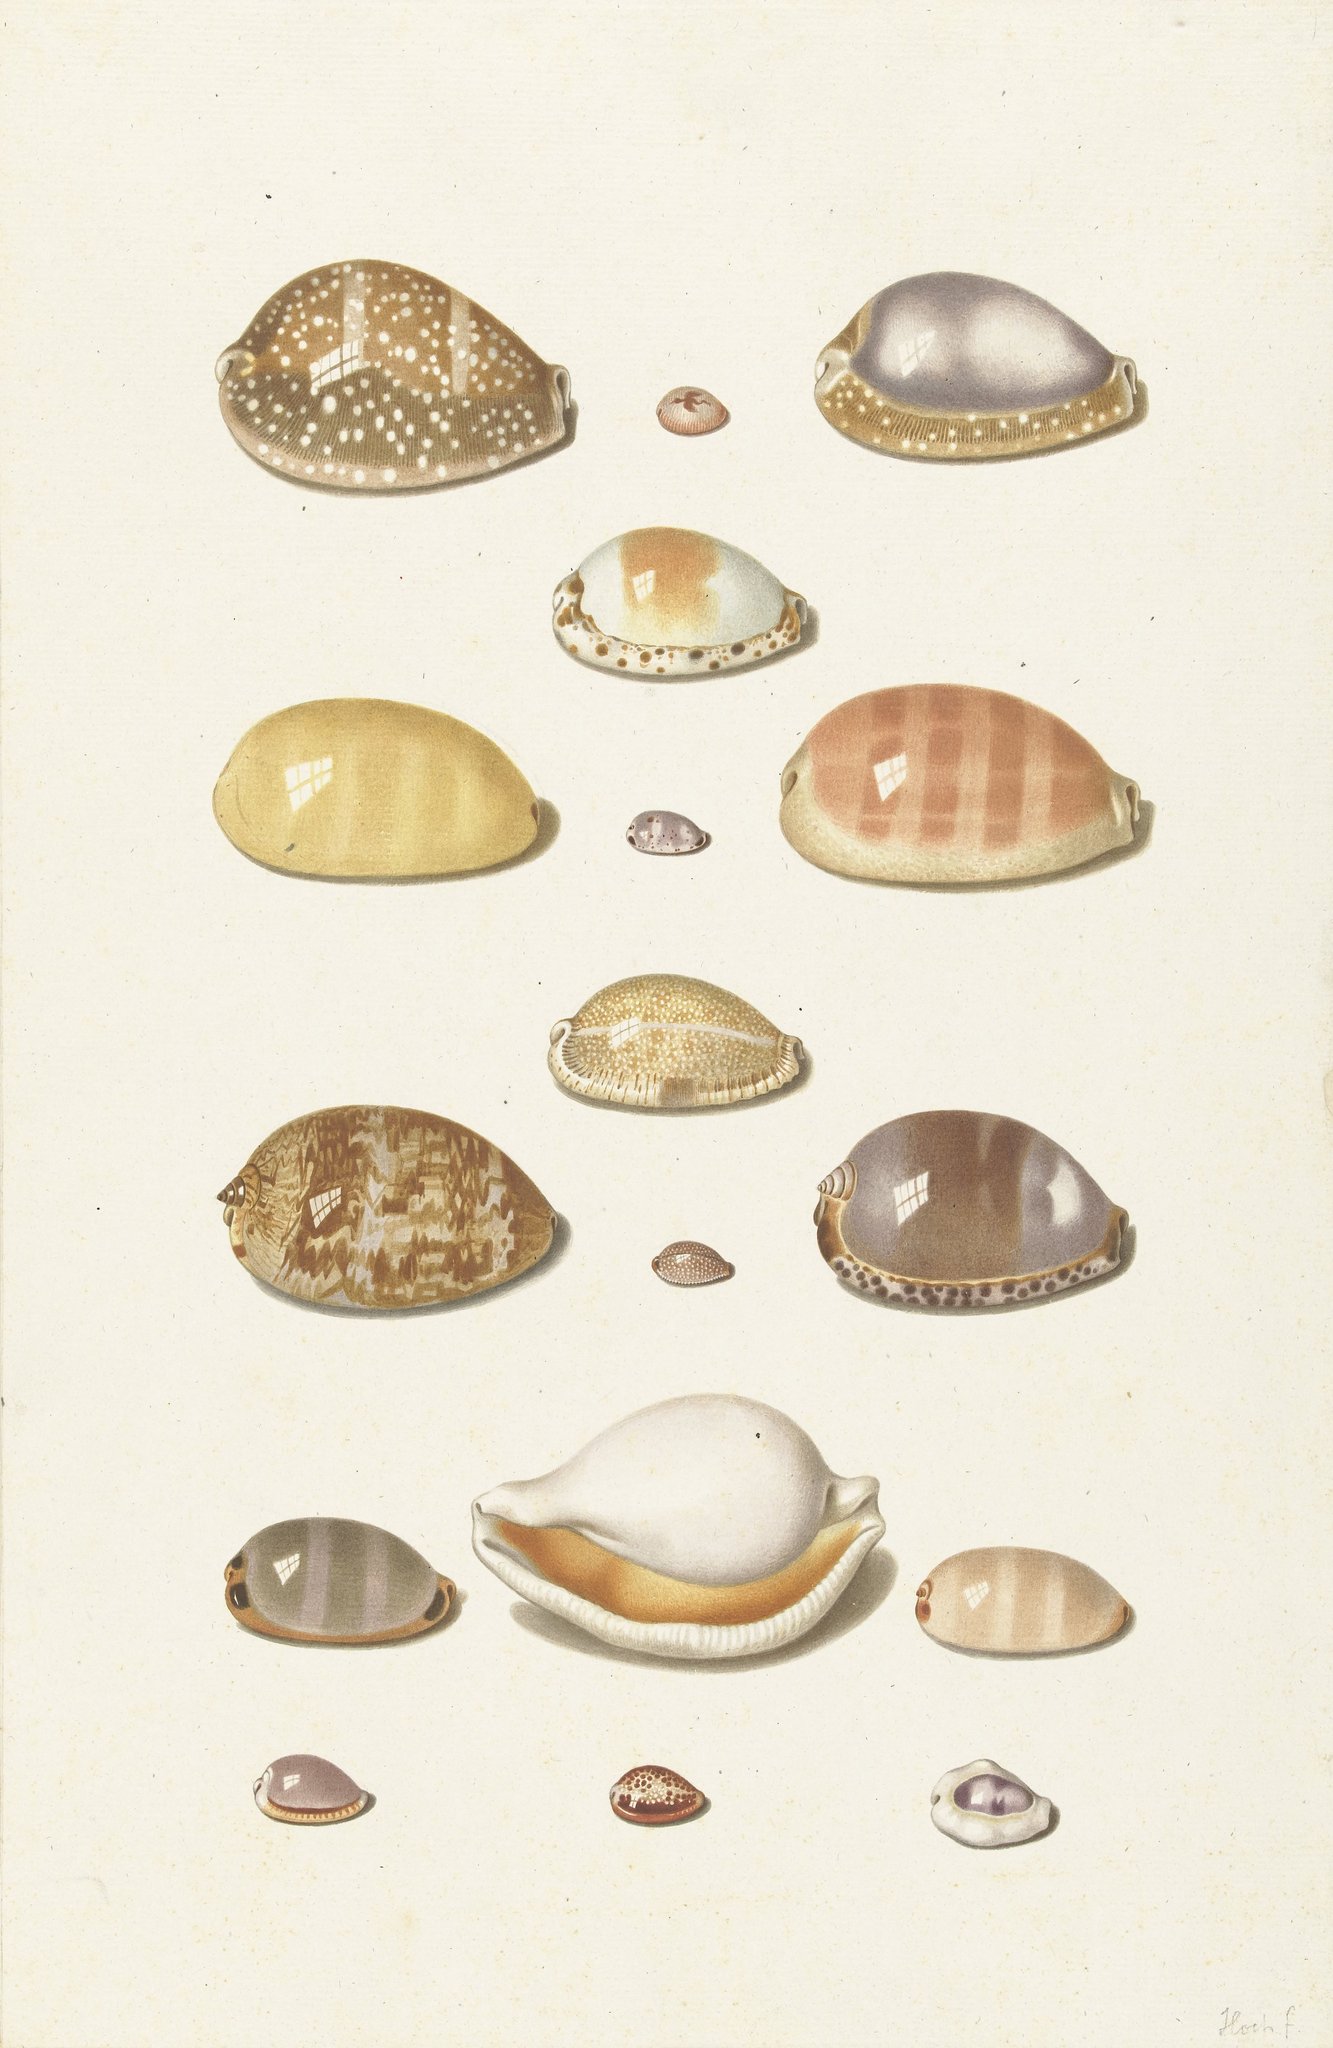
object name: watercolor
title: Cowry Shells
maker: johann gustav hoch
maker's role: painter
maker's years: 1716-1779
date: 1726-1779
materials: paper, watercolor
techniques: brush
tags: molluscs (+ shell, snail-shell etc.)